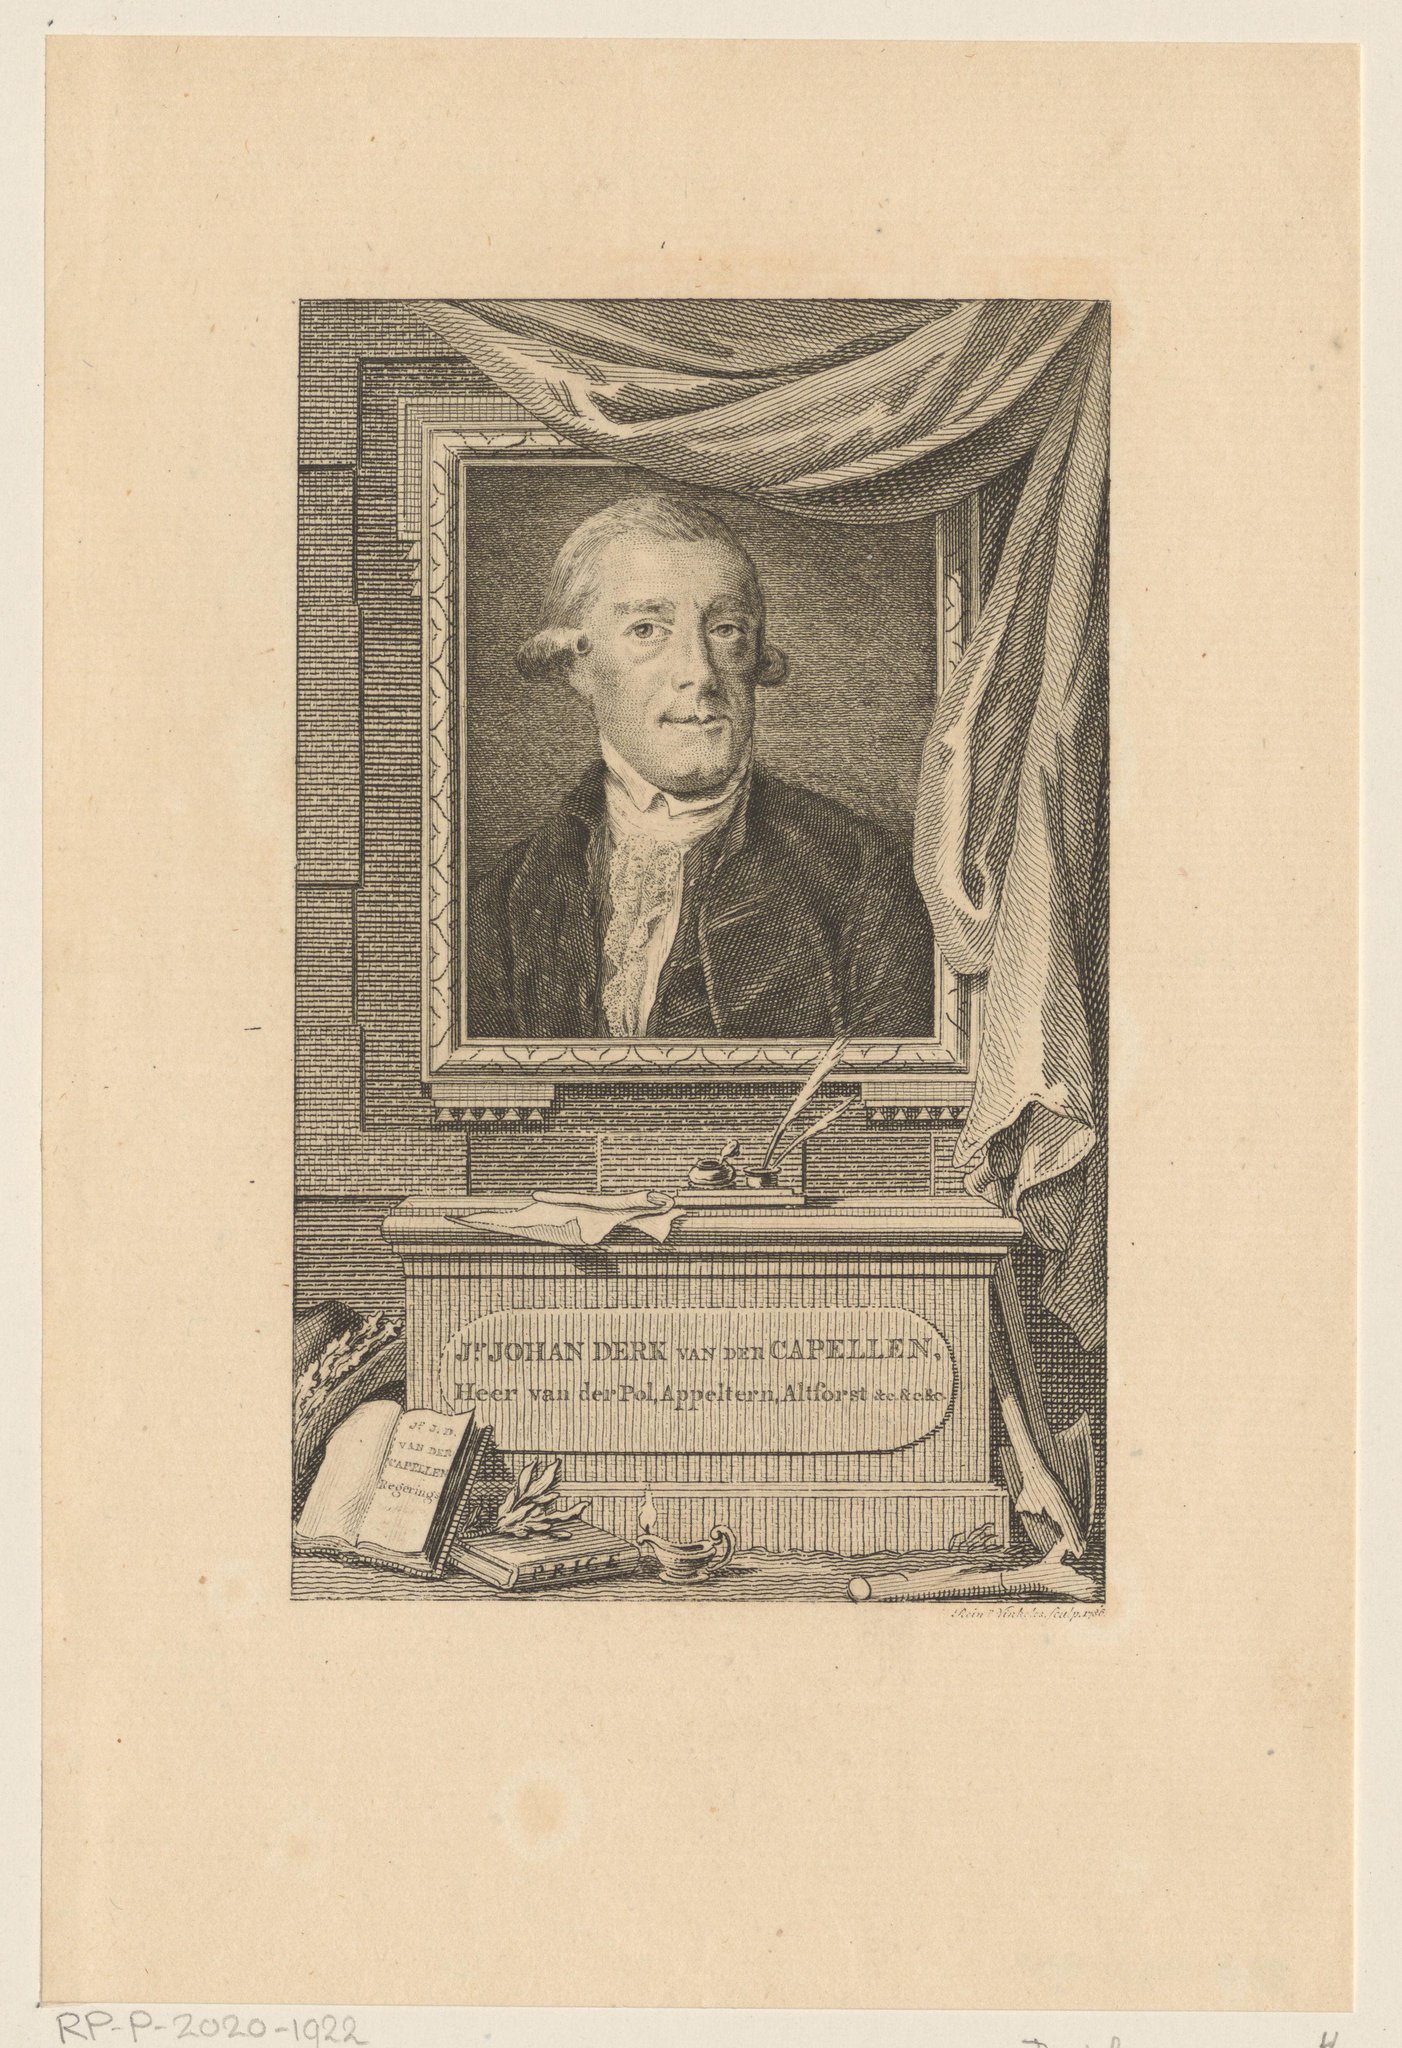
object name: print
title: Portret van Joan Derk van der Capellen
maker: reinier vinkeles (i)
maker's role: draughtsman, print maker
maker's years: 1741-1816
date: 1786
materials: paper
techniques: engraving, etching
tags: politician, joan derk van der capellen tot den pol, quill, historical persons, book - mm - book open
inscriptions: date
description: Prent mogelijk gebruikt in: Wagenaar, Jan. Vaderlandsche historie, (...) ten vervolge van Wagenaars Vaderlandsche historie. 43 dln. Amsterdam: Johannes Allart, 1786-1809.